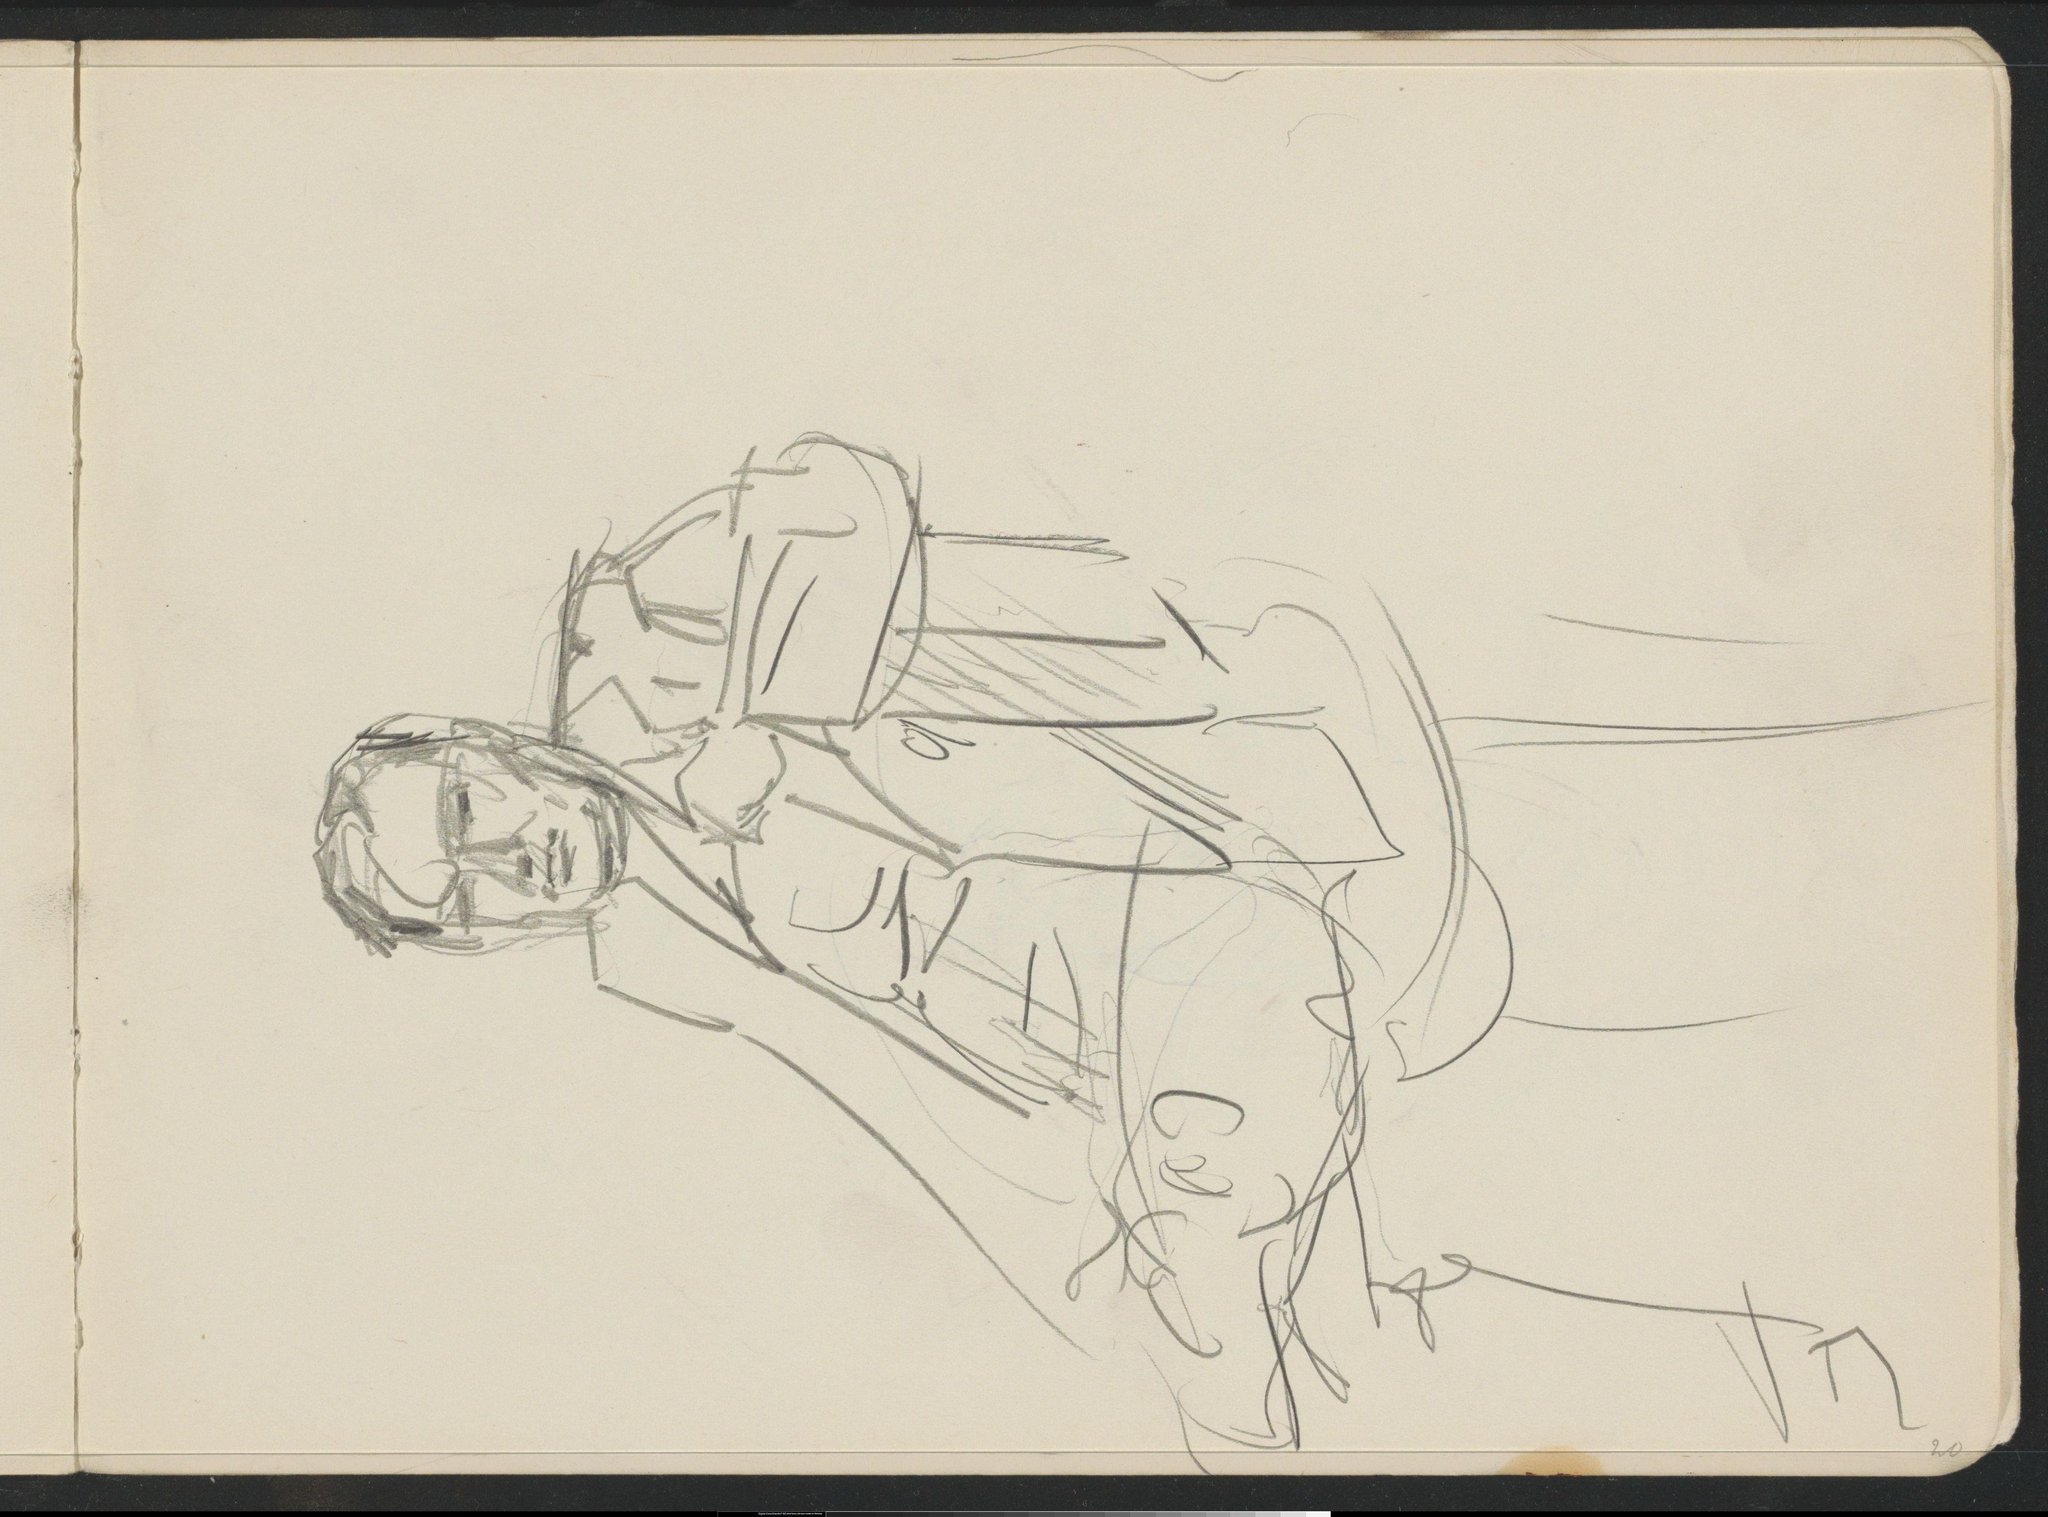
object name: sketchbook leaf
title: Man op een stoel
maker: isaac israels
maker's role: draughtsman, painter, print maker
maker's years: 1865-1934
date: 1915-1934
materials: paper, pencil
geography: the hague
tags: adult man (+ sitting)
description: De linkerarm van de man rust op de leuning. Zijn linkerbeen ligt op zijn rechterbeen. Blad 20 recto uit schetsboek XV met 22 bladen.